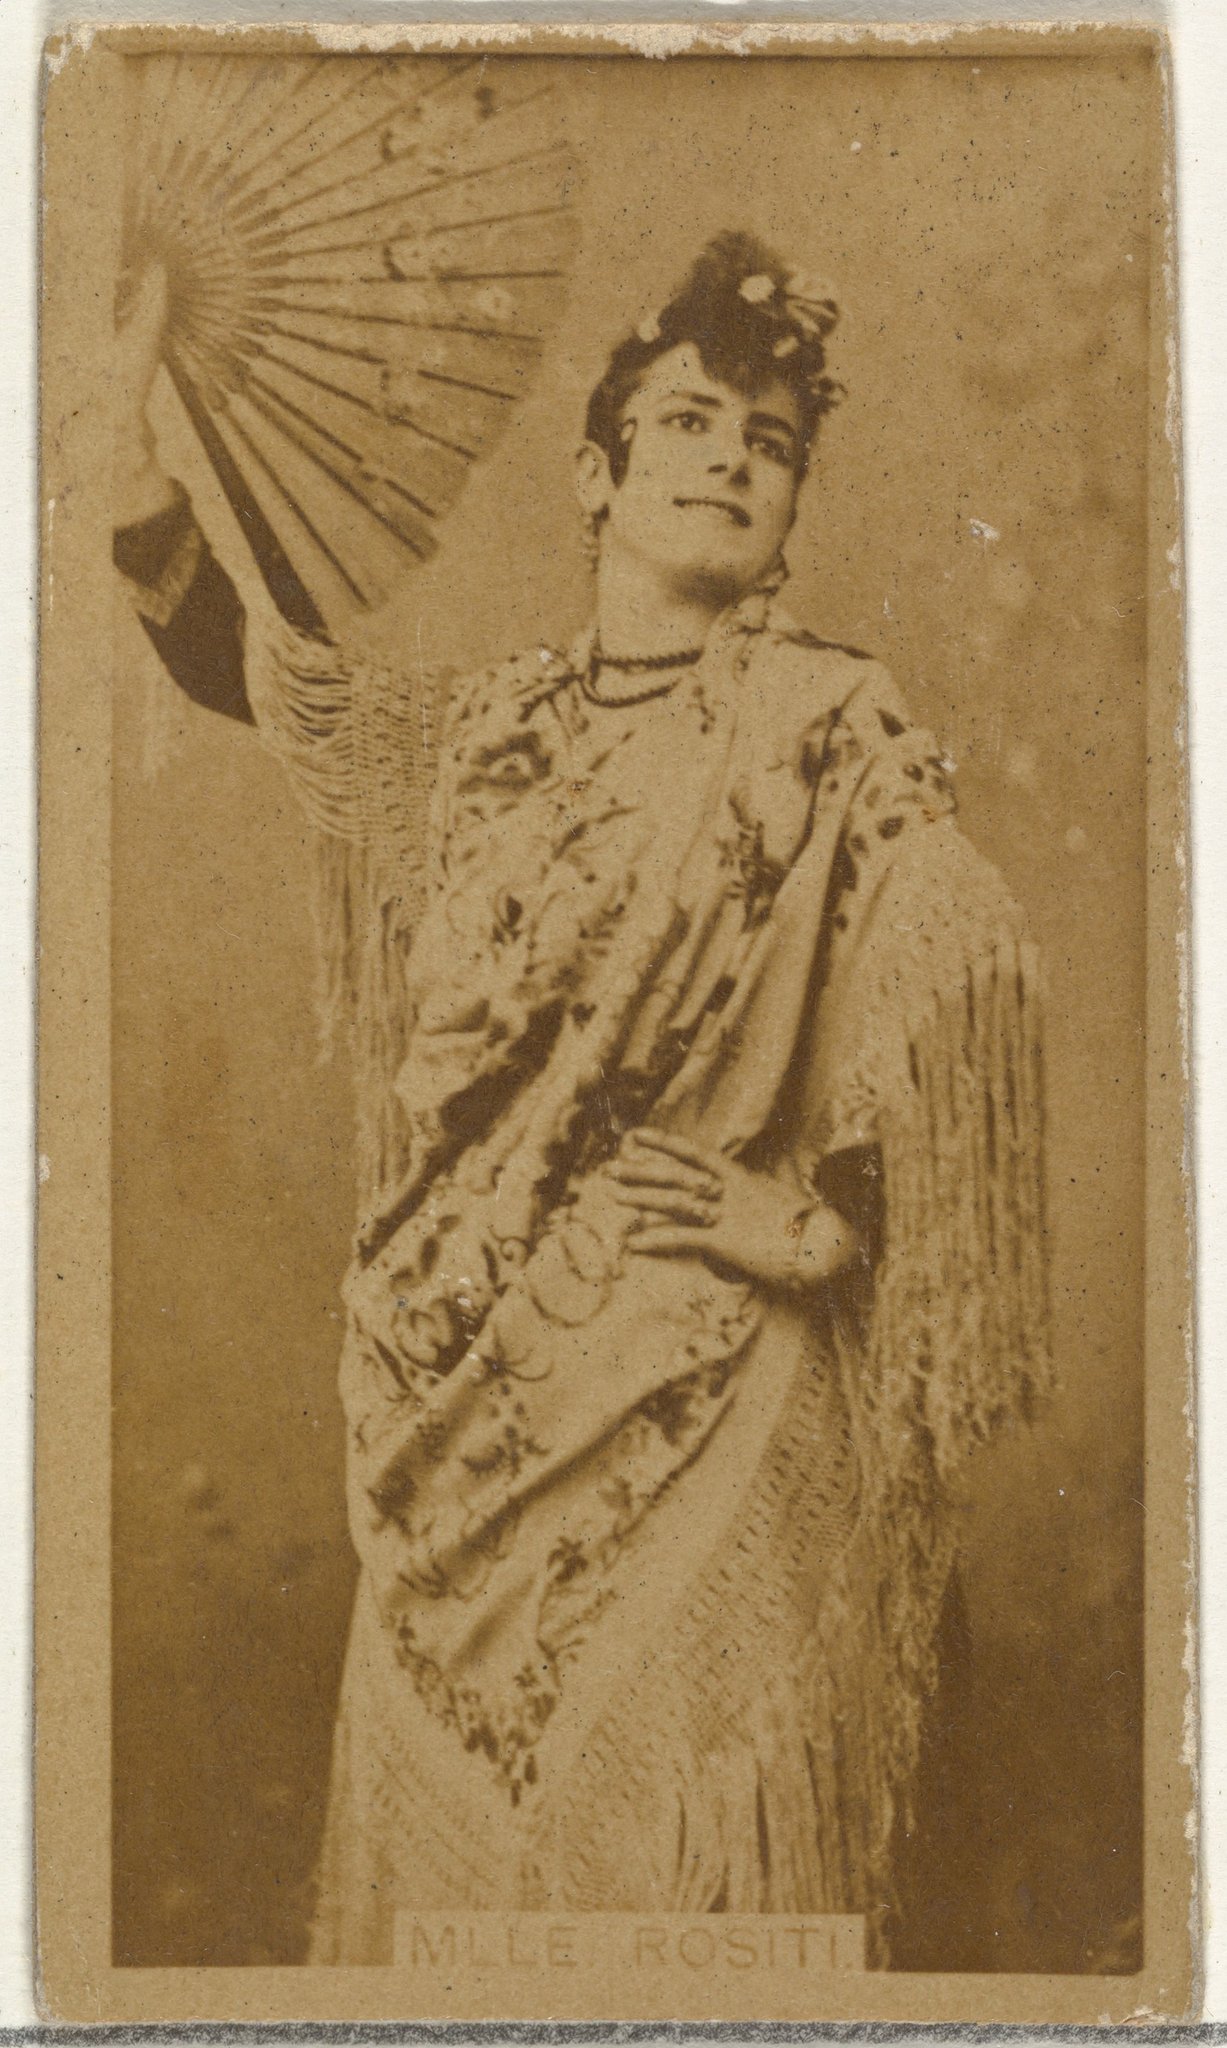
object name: photograph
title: Mlle. Rositi, from the Actors and Actresses series (N145-8) issued by Duke Sons & Co. to promote Duke Cigarettes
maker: w. duke, sons & co.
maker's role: publisher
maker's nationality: american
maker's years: 1870-1920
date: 1891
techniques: albumen silver print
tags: portraits,women,actresses